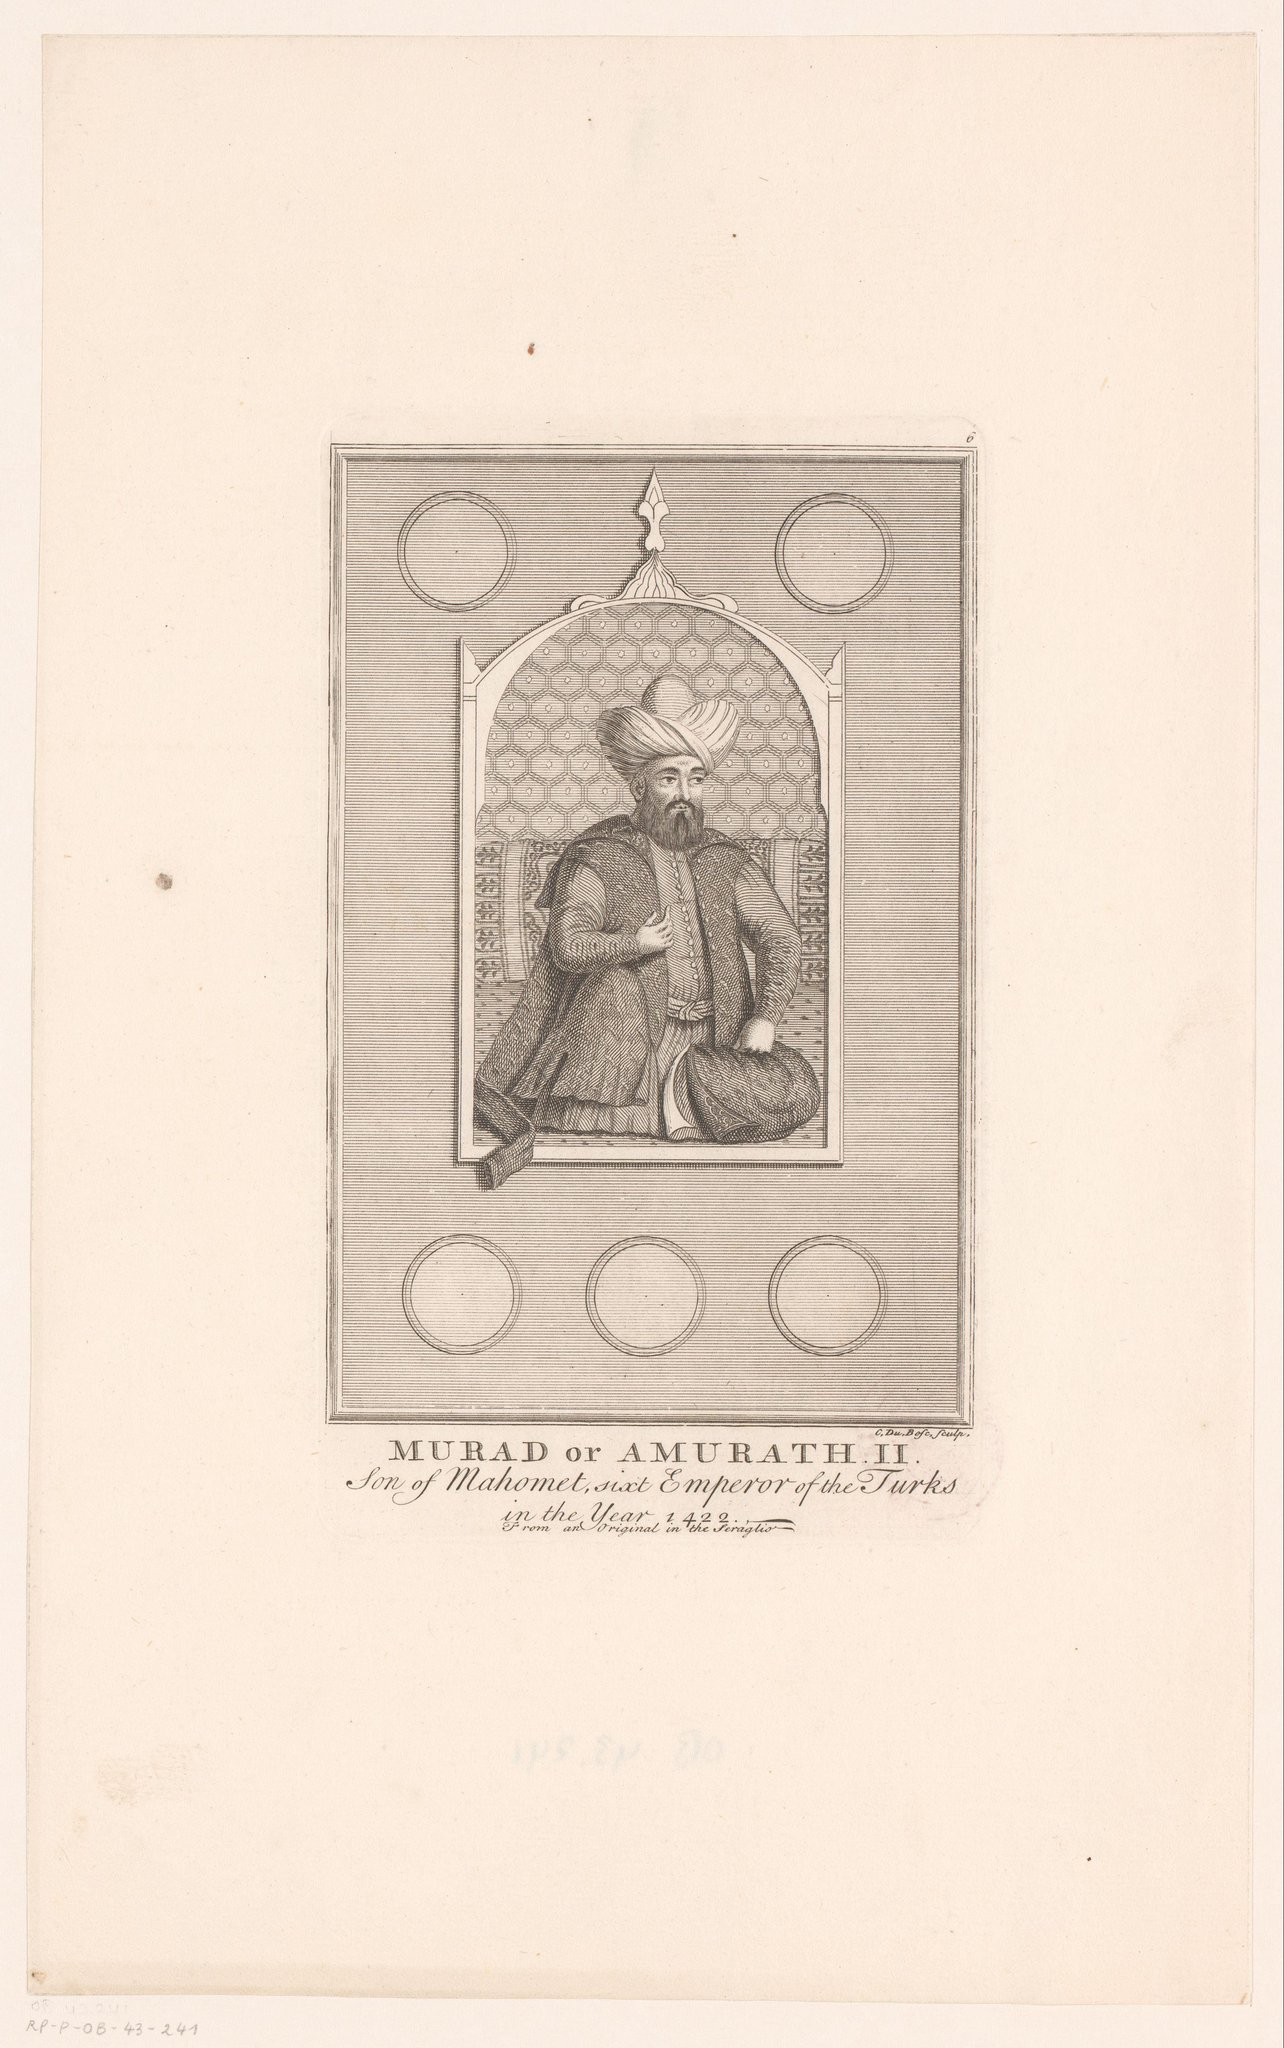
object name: print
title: Ottomaanse heersers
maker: claude dubosc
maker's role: print maker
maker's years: 1682-1745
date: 1692-1745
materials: paper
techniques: engraving, etching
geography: france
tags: historical persons, ruler, sovereign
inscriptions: collector's mark: Lugt 240